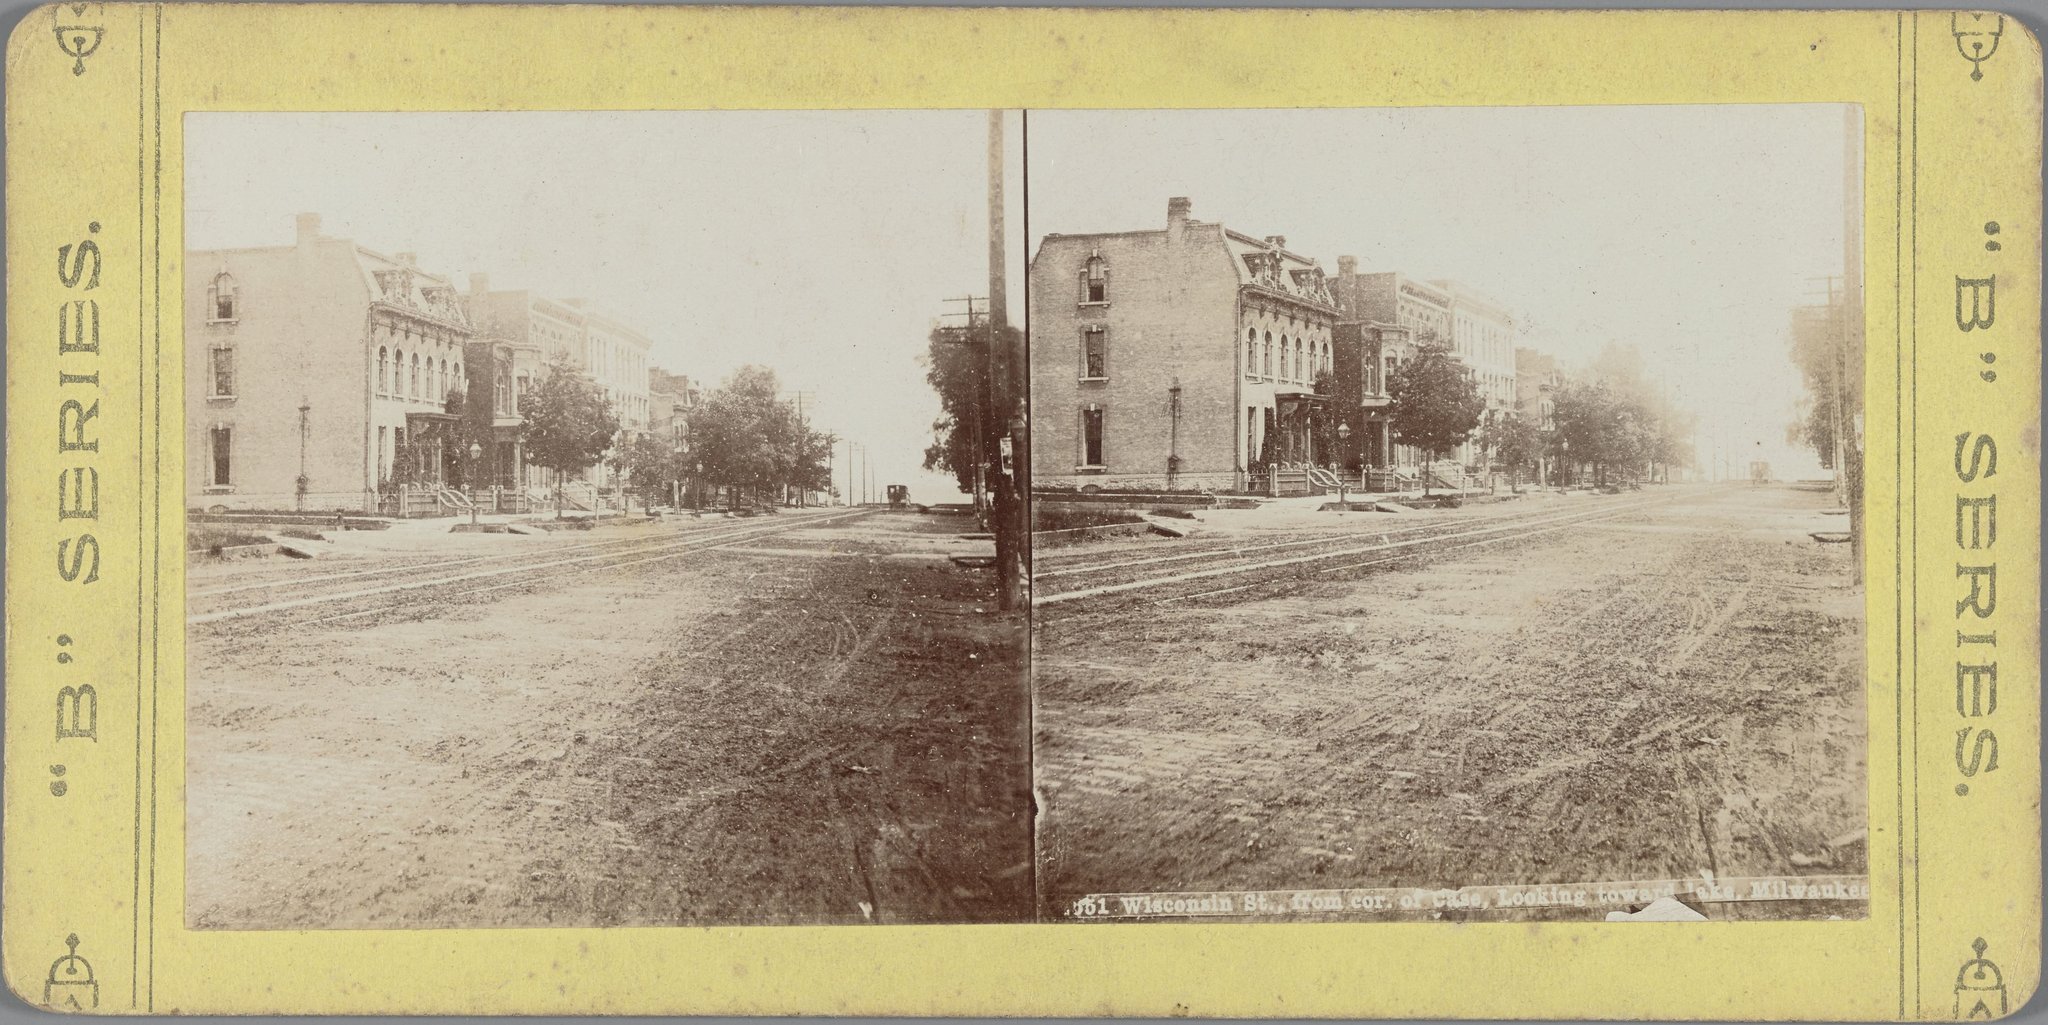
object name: stereograph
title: Wisconsin Street in Milwaukee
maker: Anonymous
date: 1880-1900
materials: cardboard, paper, photographic support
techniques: daylight paper print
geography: milwaukee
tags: street (+ city(-scape) with figures, staffage)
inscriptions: inscription: ‘R.S.’, stamp: ‘Gebr. Douwes Atelier Warmoestraat 73 Amsterdam’